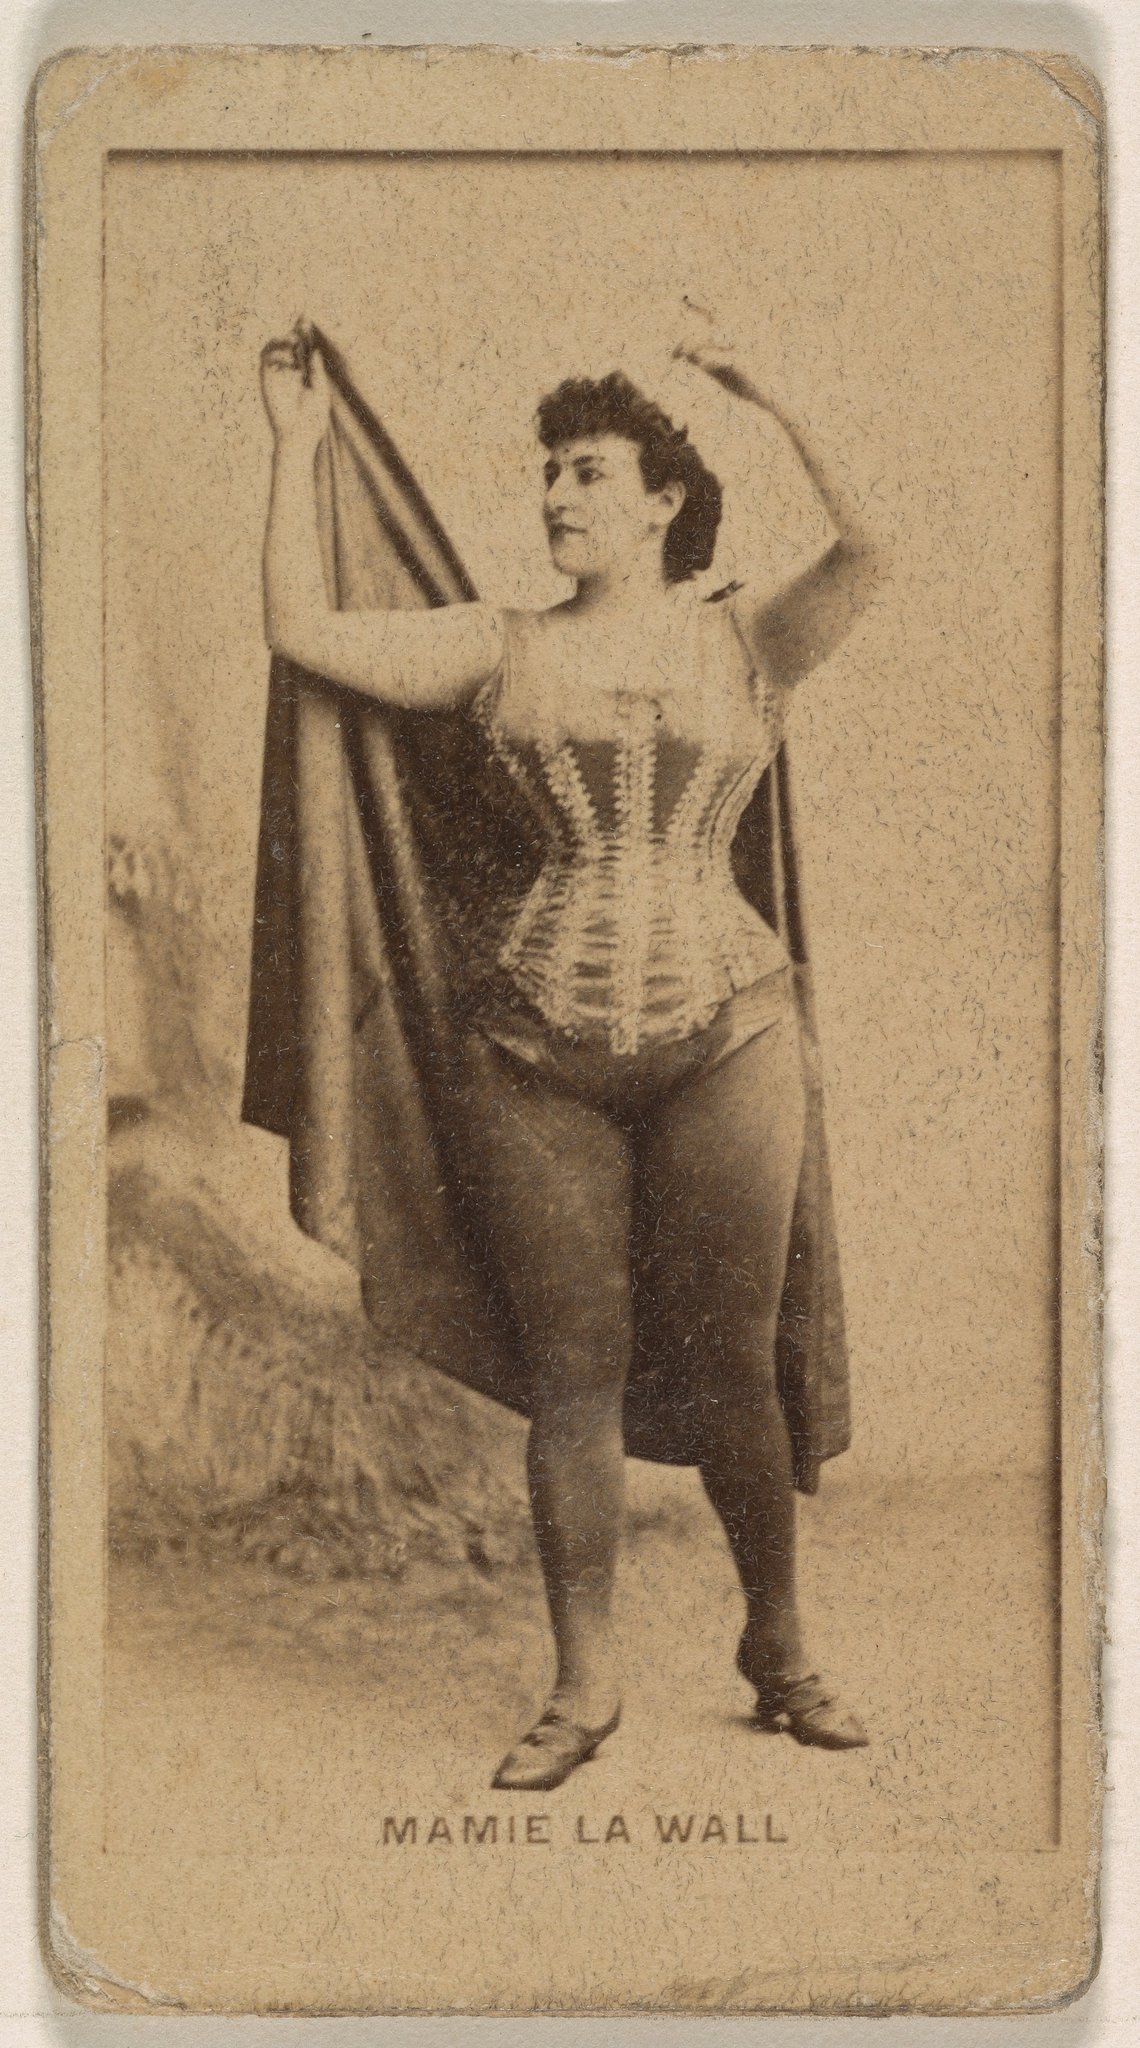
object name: photograph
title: Mamie La Wall, from the Actresses series (N245) issued by Kinney Brothers to promote Sweet Caporal Cigarettes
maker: kinney brothers tobacco company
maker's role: publisher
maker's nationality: american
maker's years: 1869-2011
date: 1890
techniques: albumen silver print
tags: portraits,women,actresses